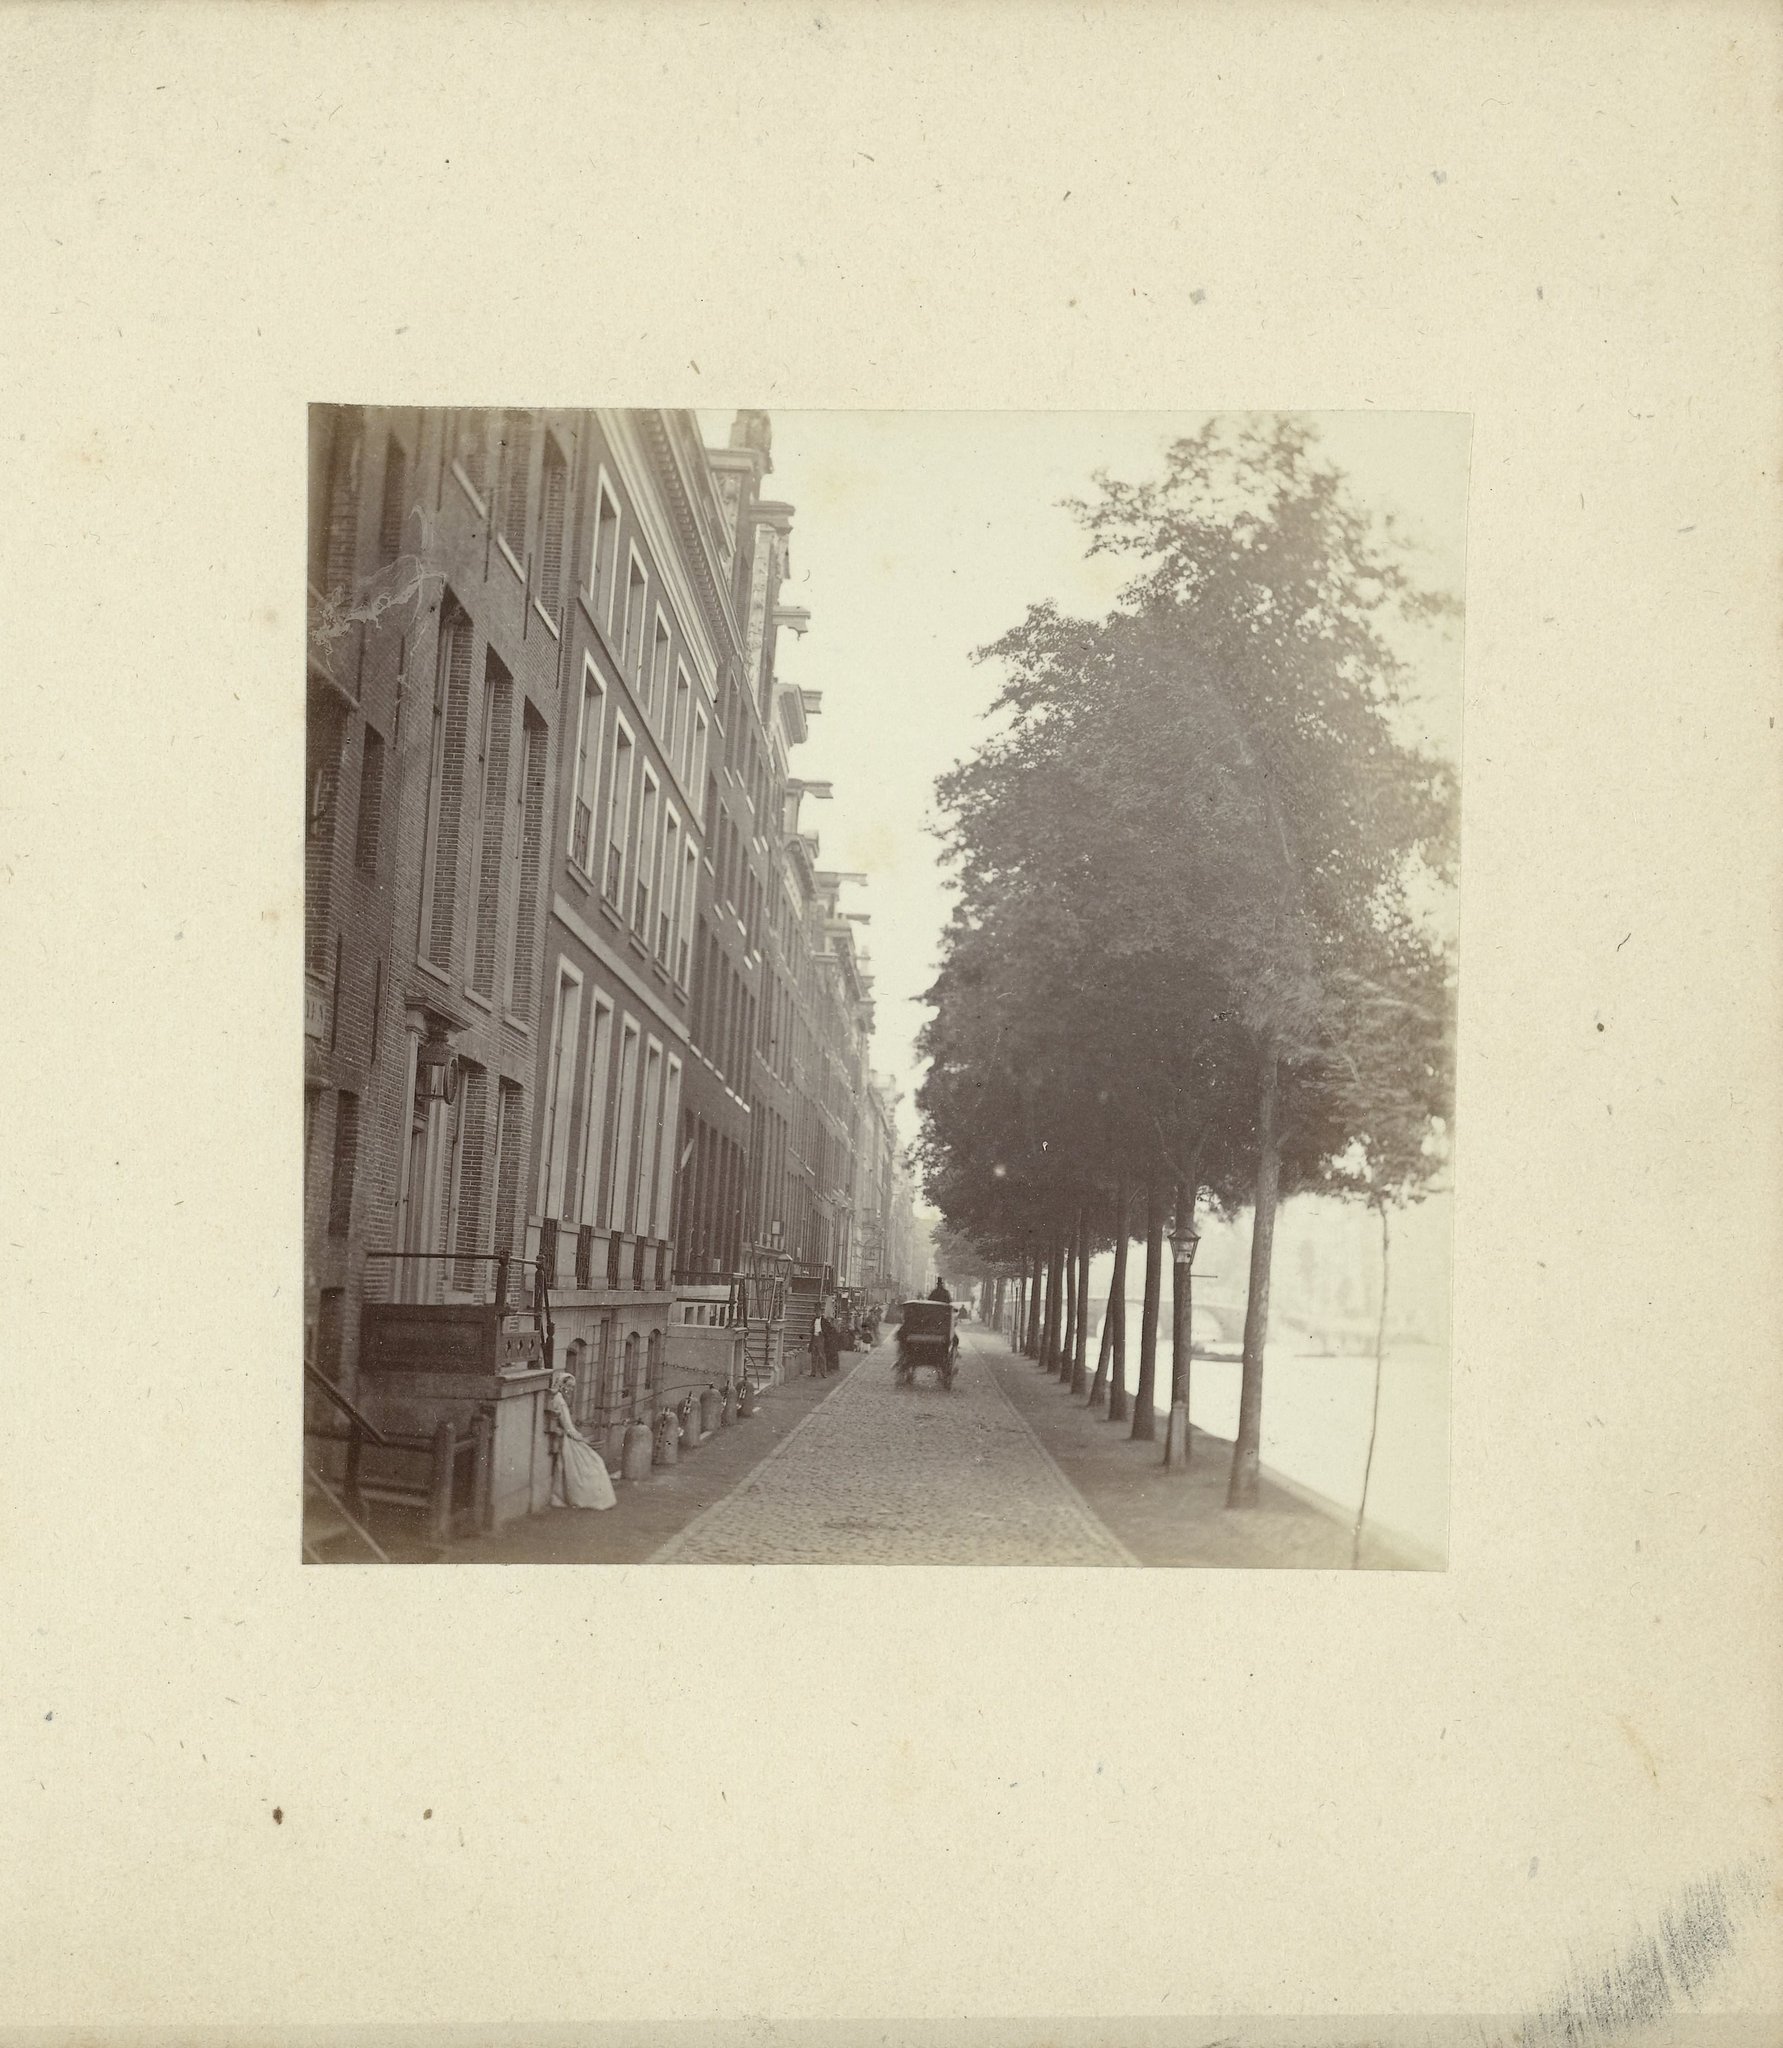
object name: photograph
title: Keizersgracht bij de Reguliersgracht in Amsterdam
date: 1860-1875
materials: cardboard, paper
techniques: albumen print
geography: amsterdam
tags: street